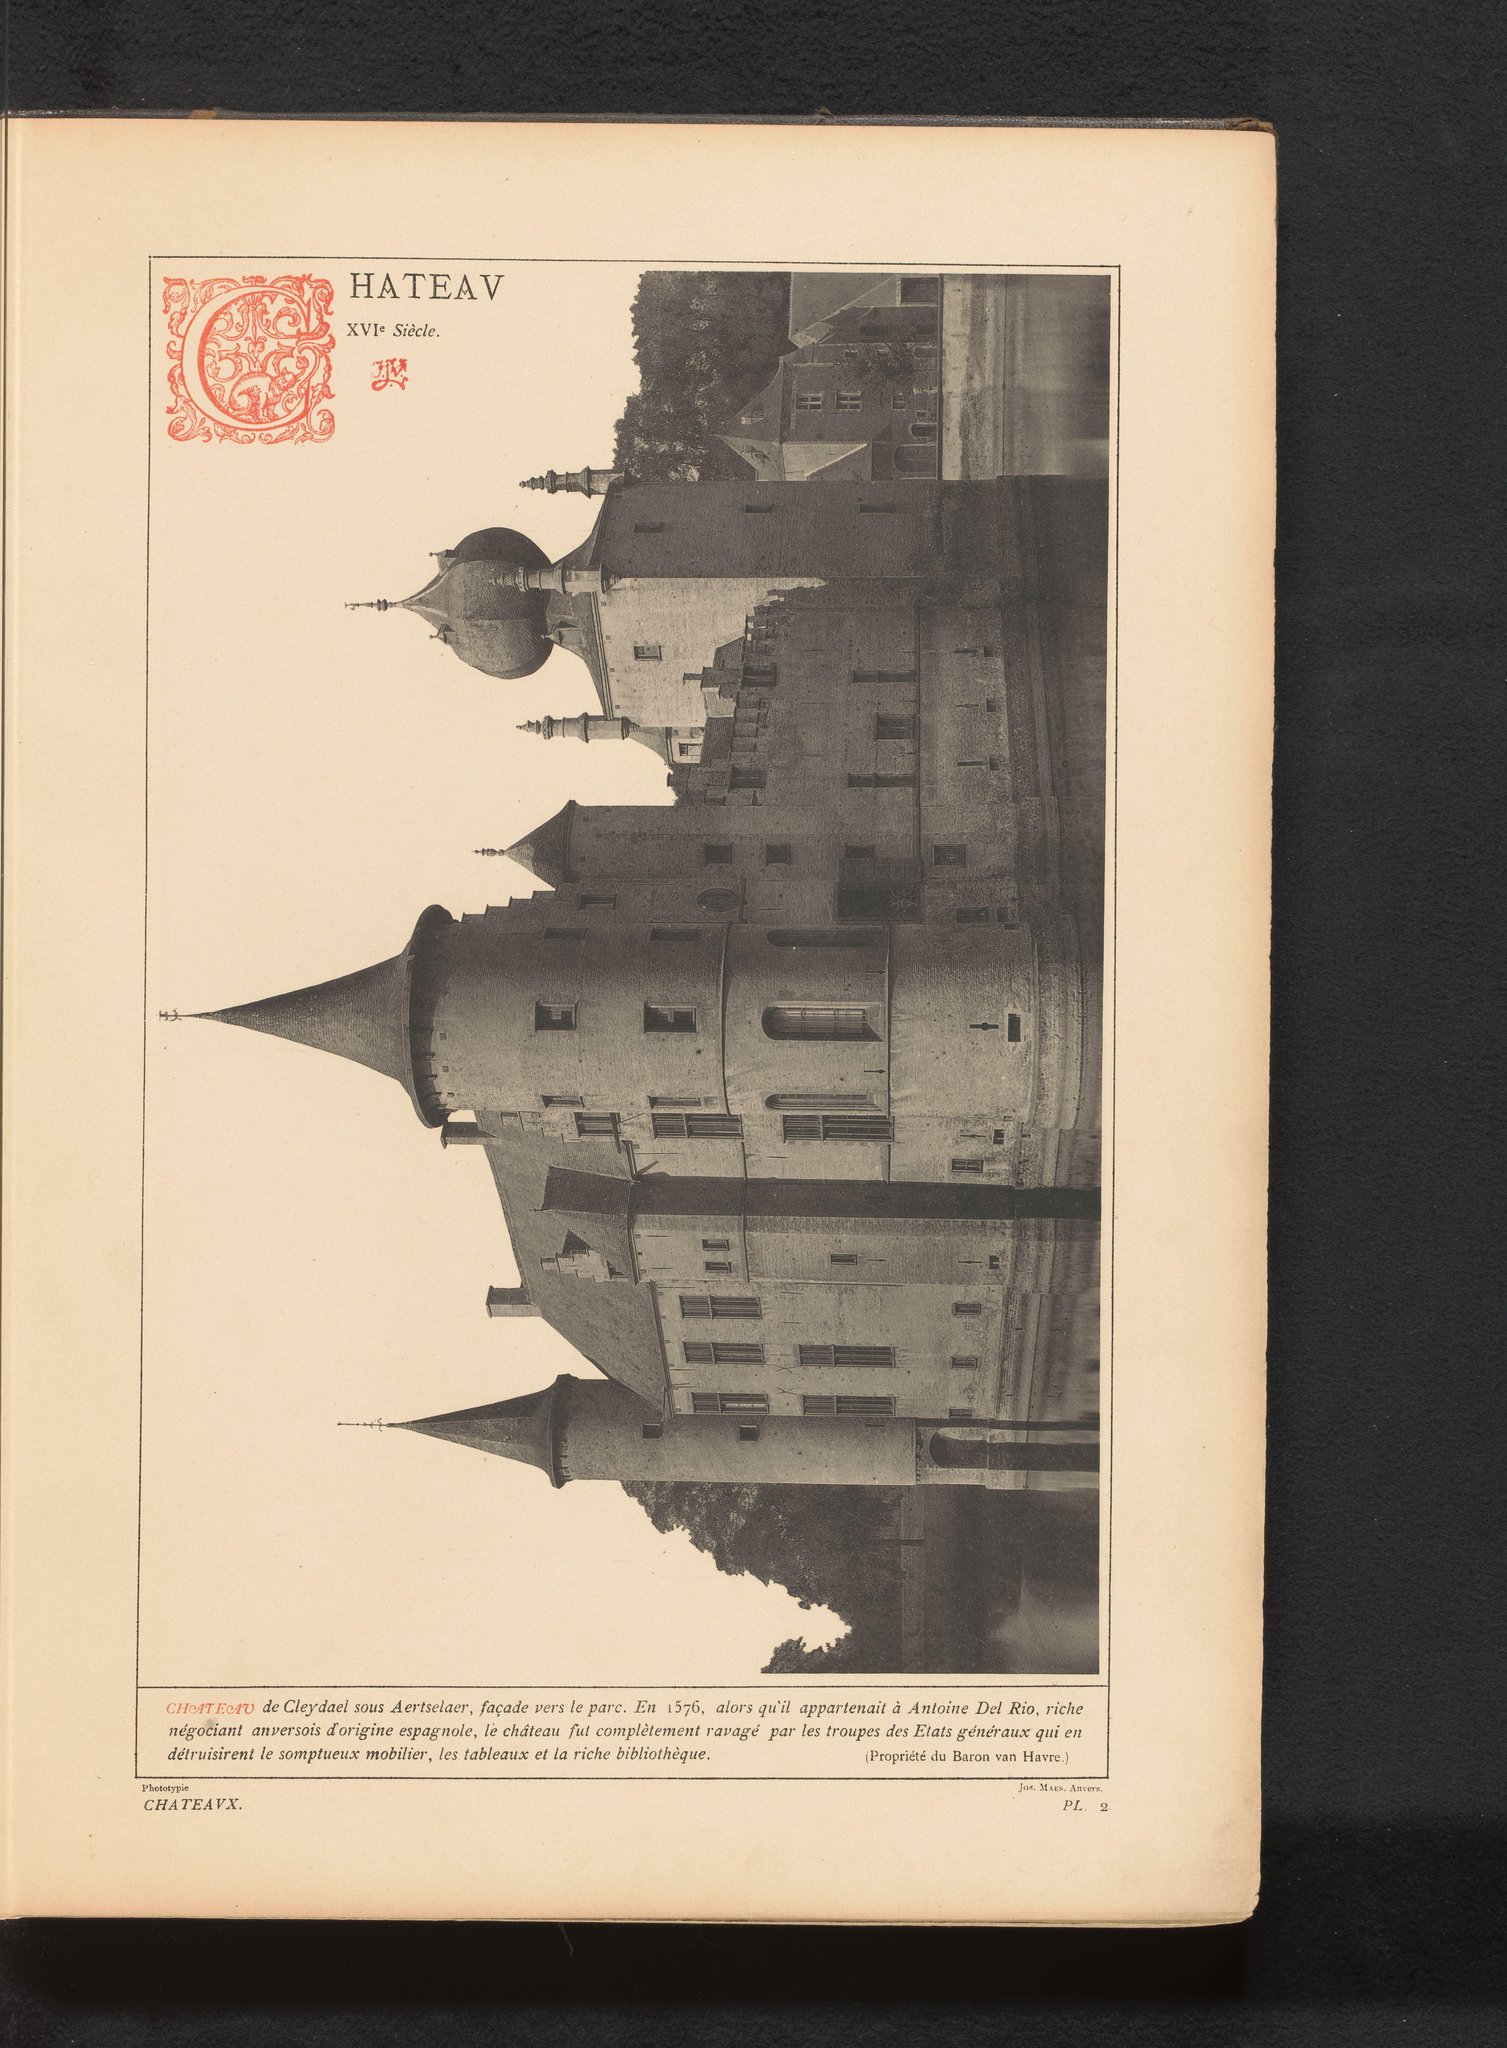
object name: page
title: Gezicht op kasteel Cleydael te Aartselaar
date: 1881-1889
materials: paper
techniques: photograph, photolithography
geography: antwerp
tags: castle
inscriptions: inscription: ‘CHATEAU de Cleydael (...)’, inscription: ‘CHATEAU. PL.2.’, monogram: ‘JJvY’